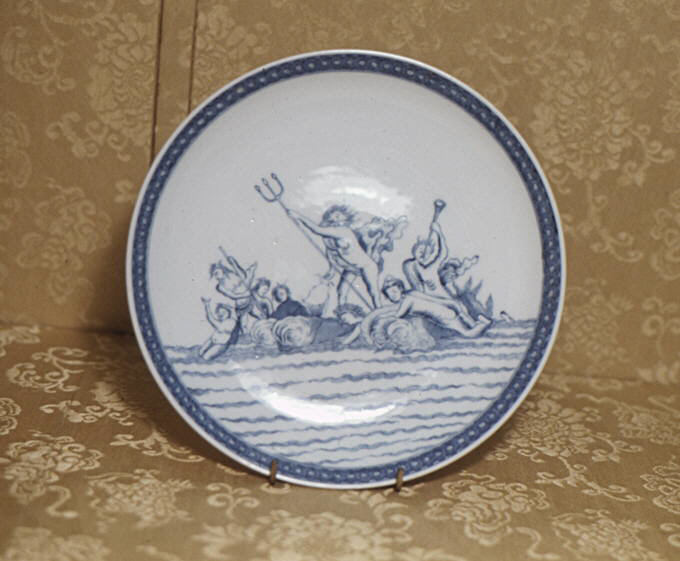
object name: plate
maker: abraham bloemaert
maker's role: artist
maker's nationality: netherlandish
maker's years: 1566-1651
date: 1730-1735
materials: hard paste porcelain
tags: nymphs,neptune